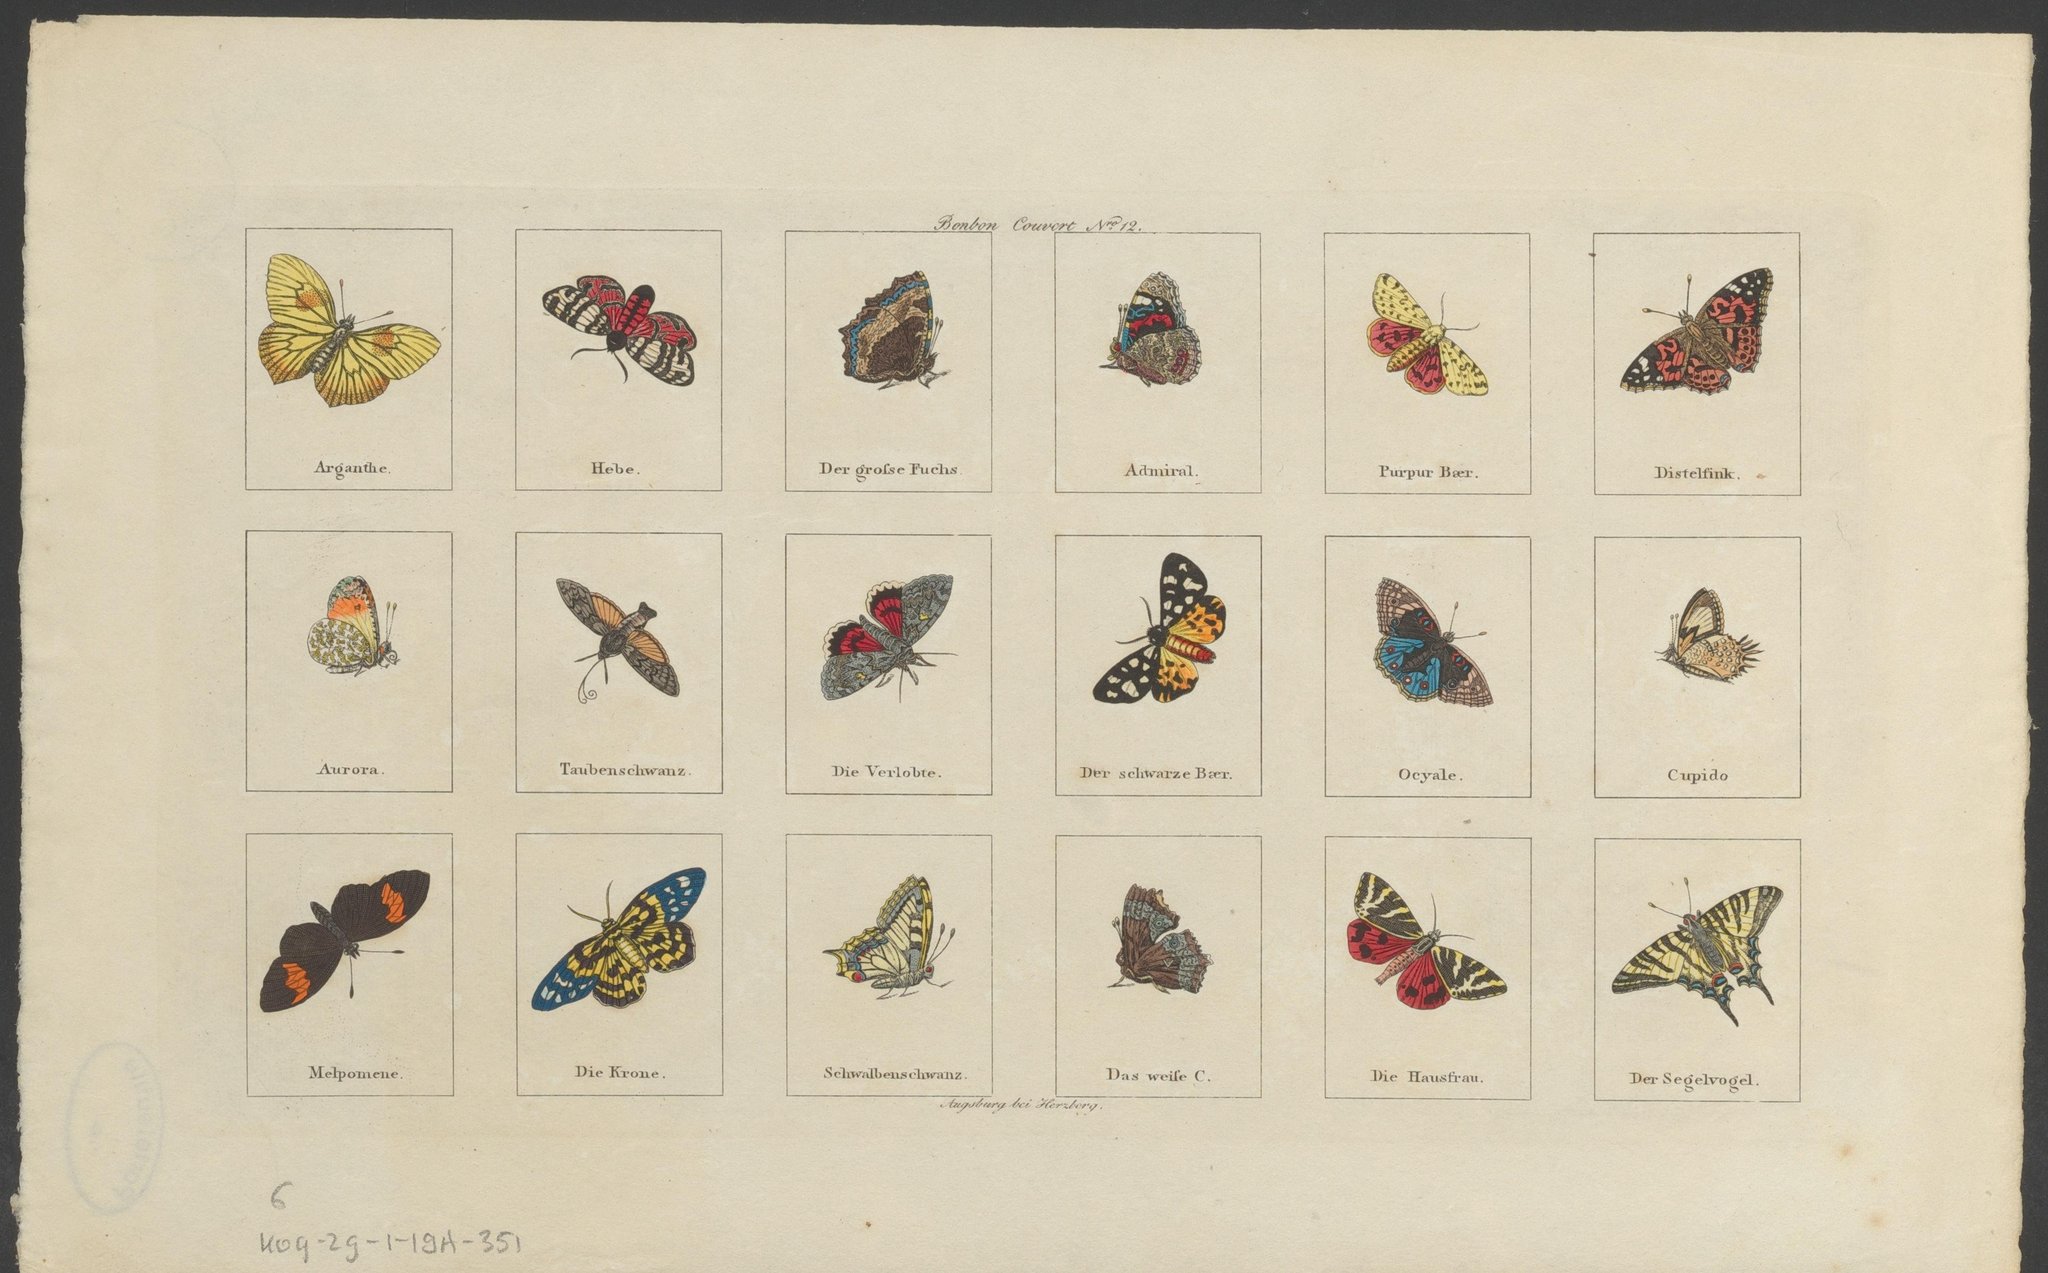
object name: print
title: Achttien vlinders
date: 1801-1855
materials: paper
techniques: engraving, etching, hand coloring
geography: augsburg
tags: insects: butterfly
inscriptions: stamp, collector's mark: Lugt 1641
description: Achttien verschillende vlinders in drie rijen van zes. Onder iedere vlinder de naam in Duits. Bovenaan genummerd: Nro. 12. Onderwerpsrubrieken binnen de Atlas Zeden en Gewoonten: Zeden en Gewoonten in Engeren Zin, Des menschen beging, midden en einde, Kinderleven – Kinderspel en Kinderprenten.